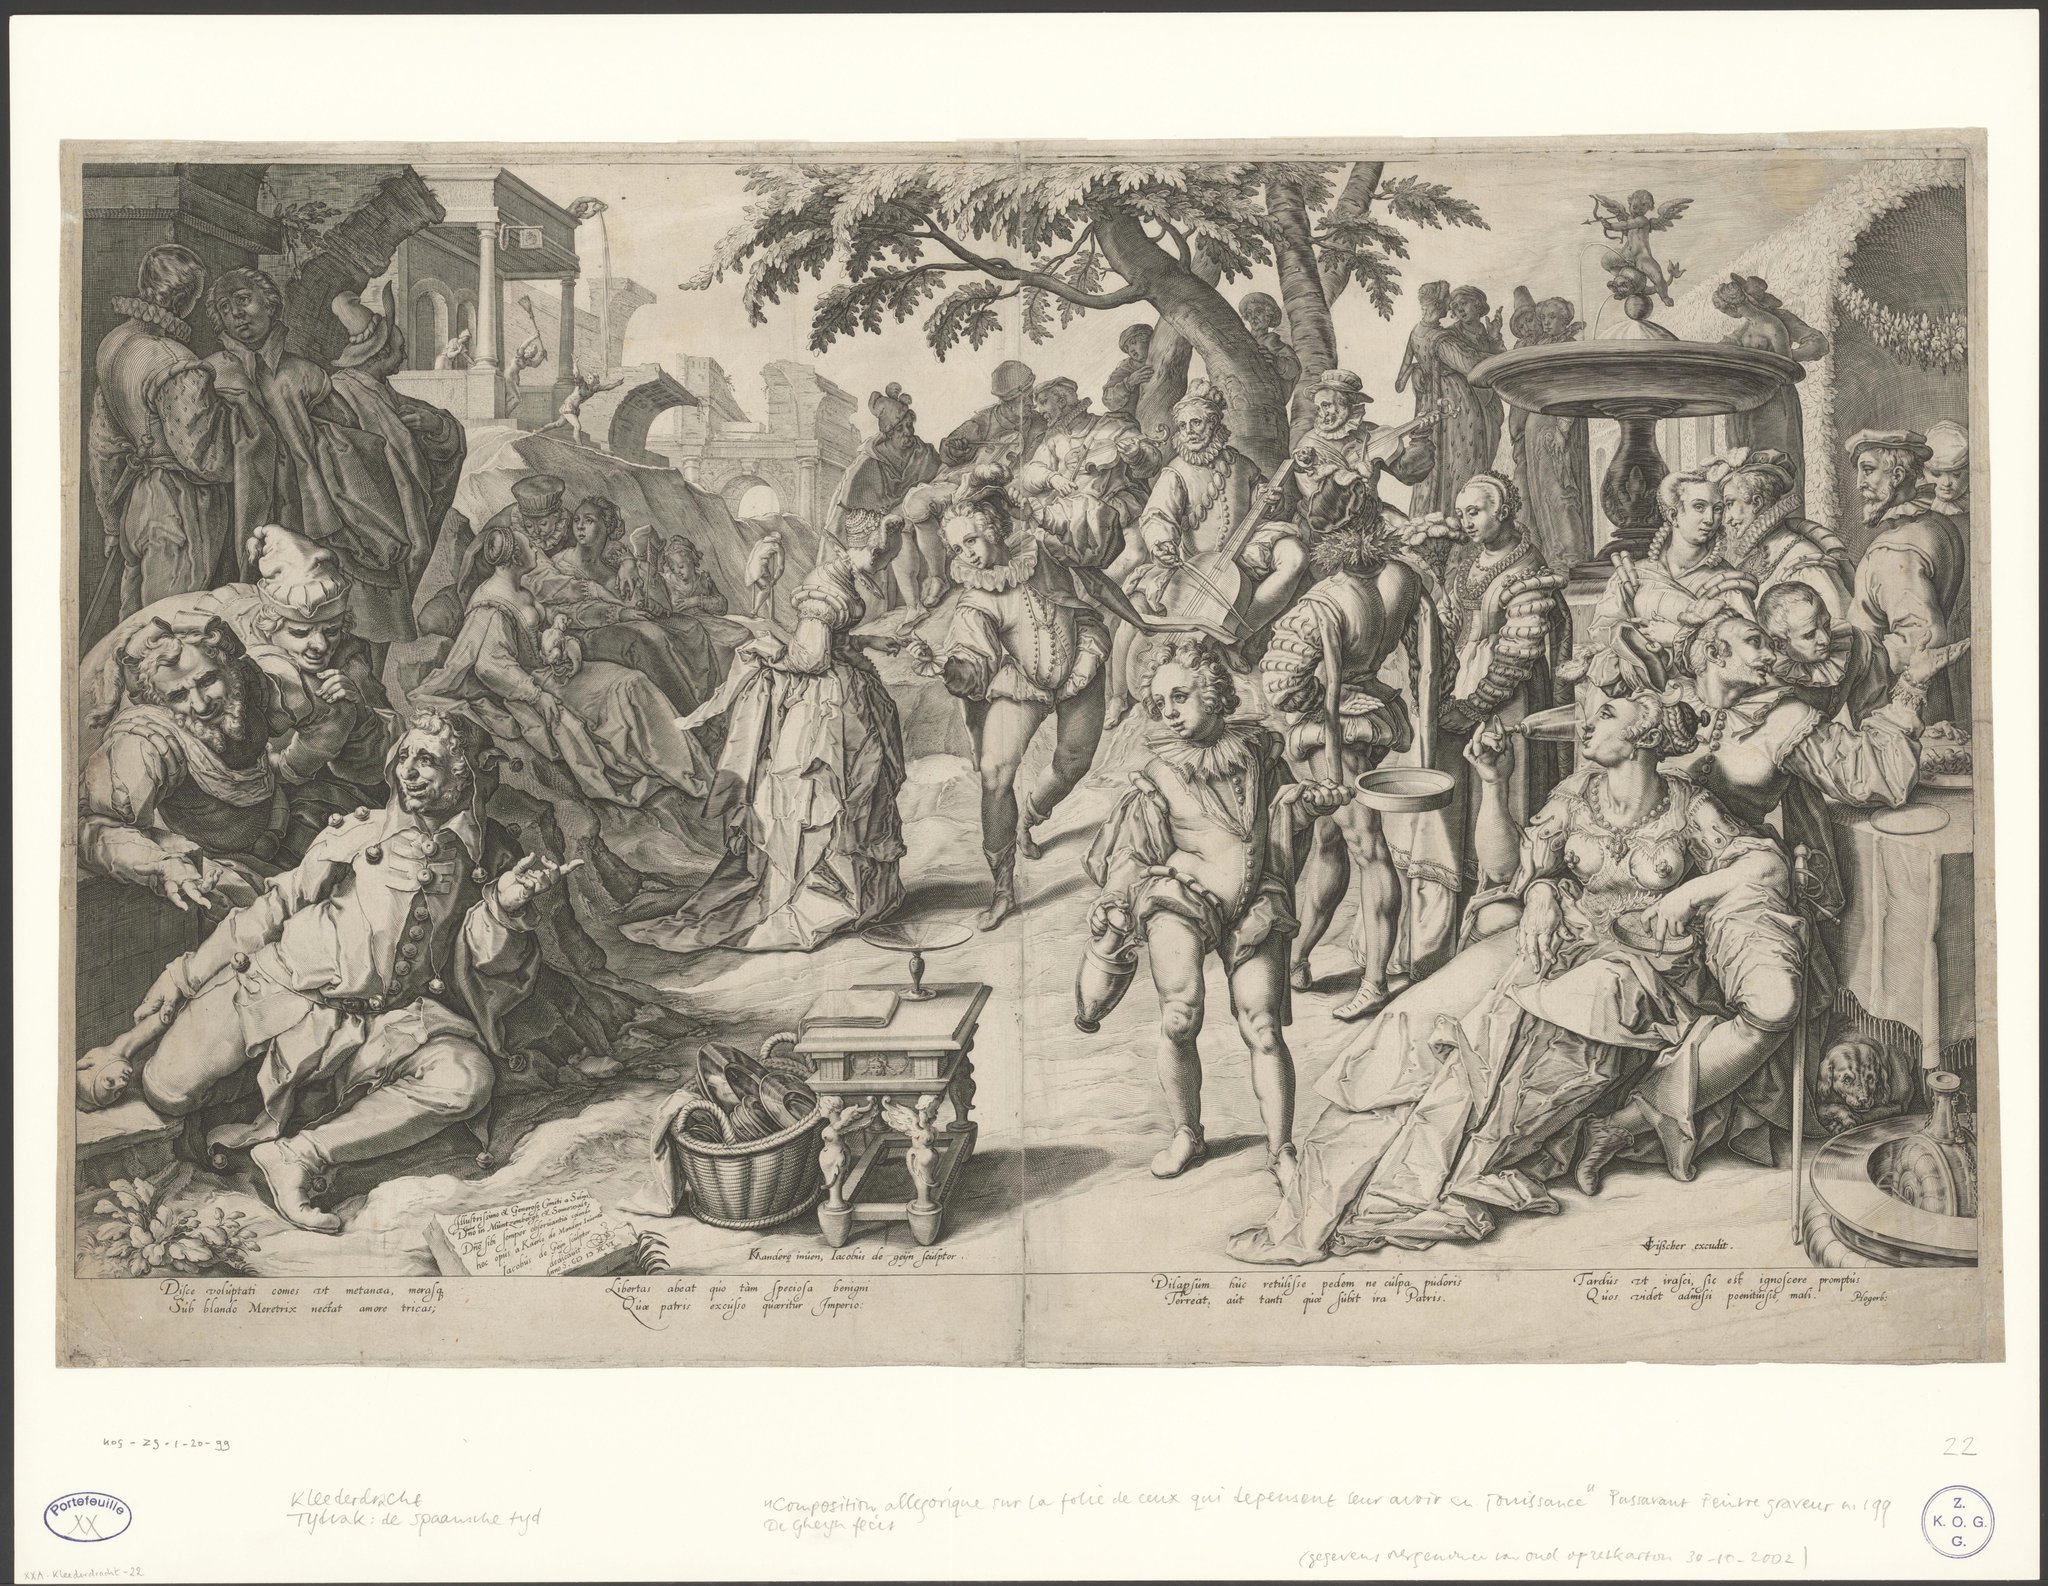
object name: print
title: Verloren zoon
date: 1596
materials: paper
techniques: engraving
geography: amsterdam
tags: the parable of the prodigal son (luke 15:11-32)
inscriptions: collector's mark: Lugt 1641, stamp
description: Voorstelling op twee bladen van een gezelschap dat zich in de buitenlucht bij een fontein vermaakt met eten, drinken, muziek en vrijages. Op de achtergrond is te zien hoe een man weggejaagd wordt uit een gebouw. Onder de voorstelling een achtregelig Latijns gedicht. Onderwerpsrubrieken binnen de Atlas Zeden en Gewoonten: Zeden en Gewoonten in Engeren Zin, De Kleeding, Kleederdrachten (tijdvakken), De Spaansche tijd. (1550 – 1600).